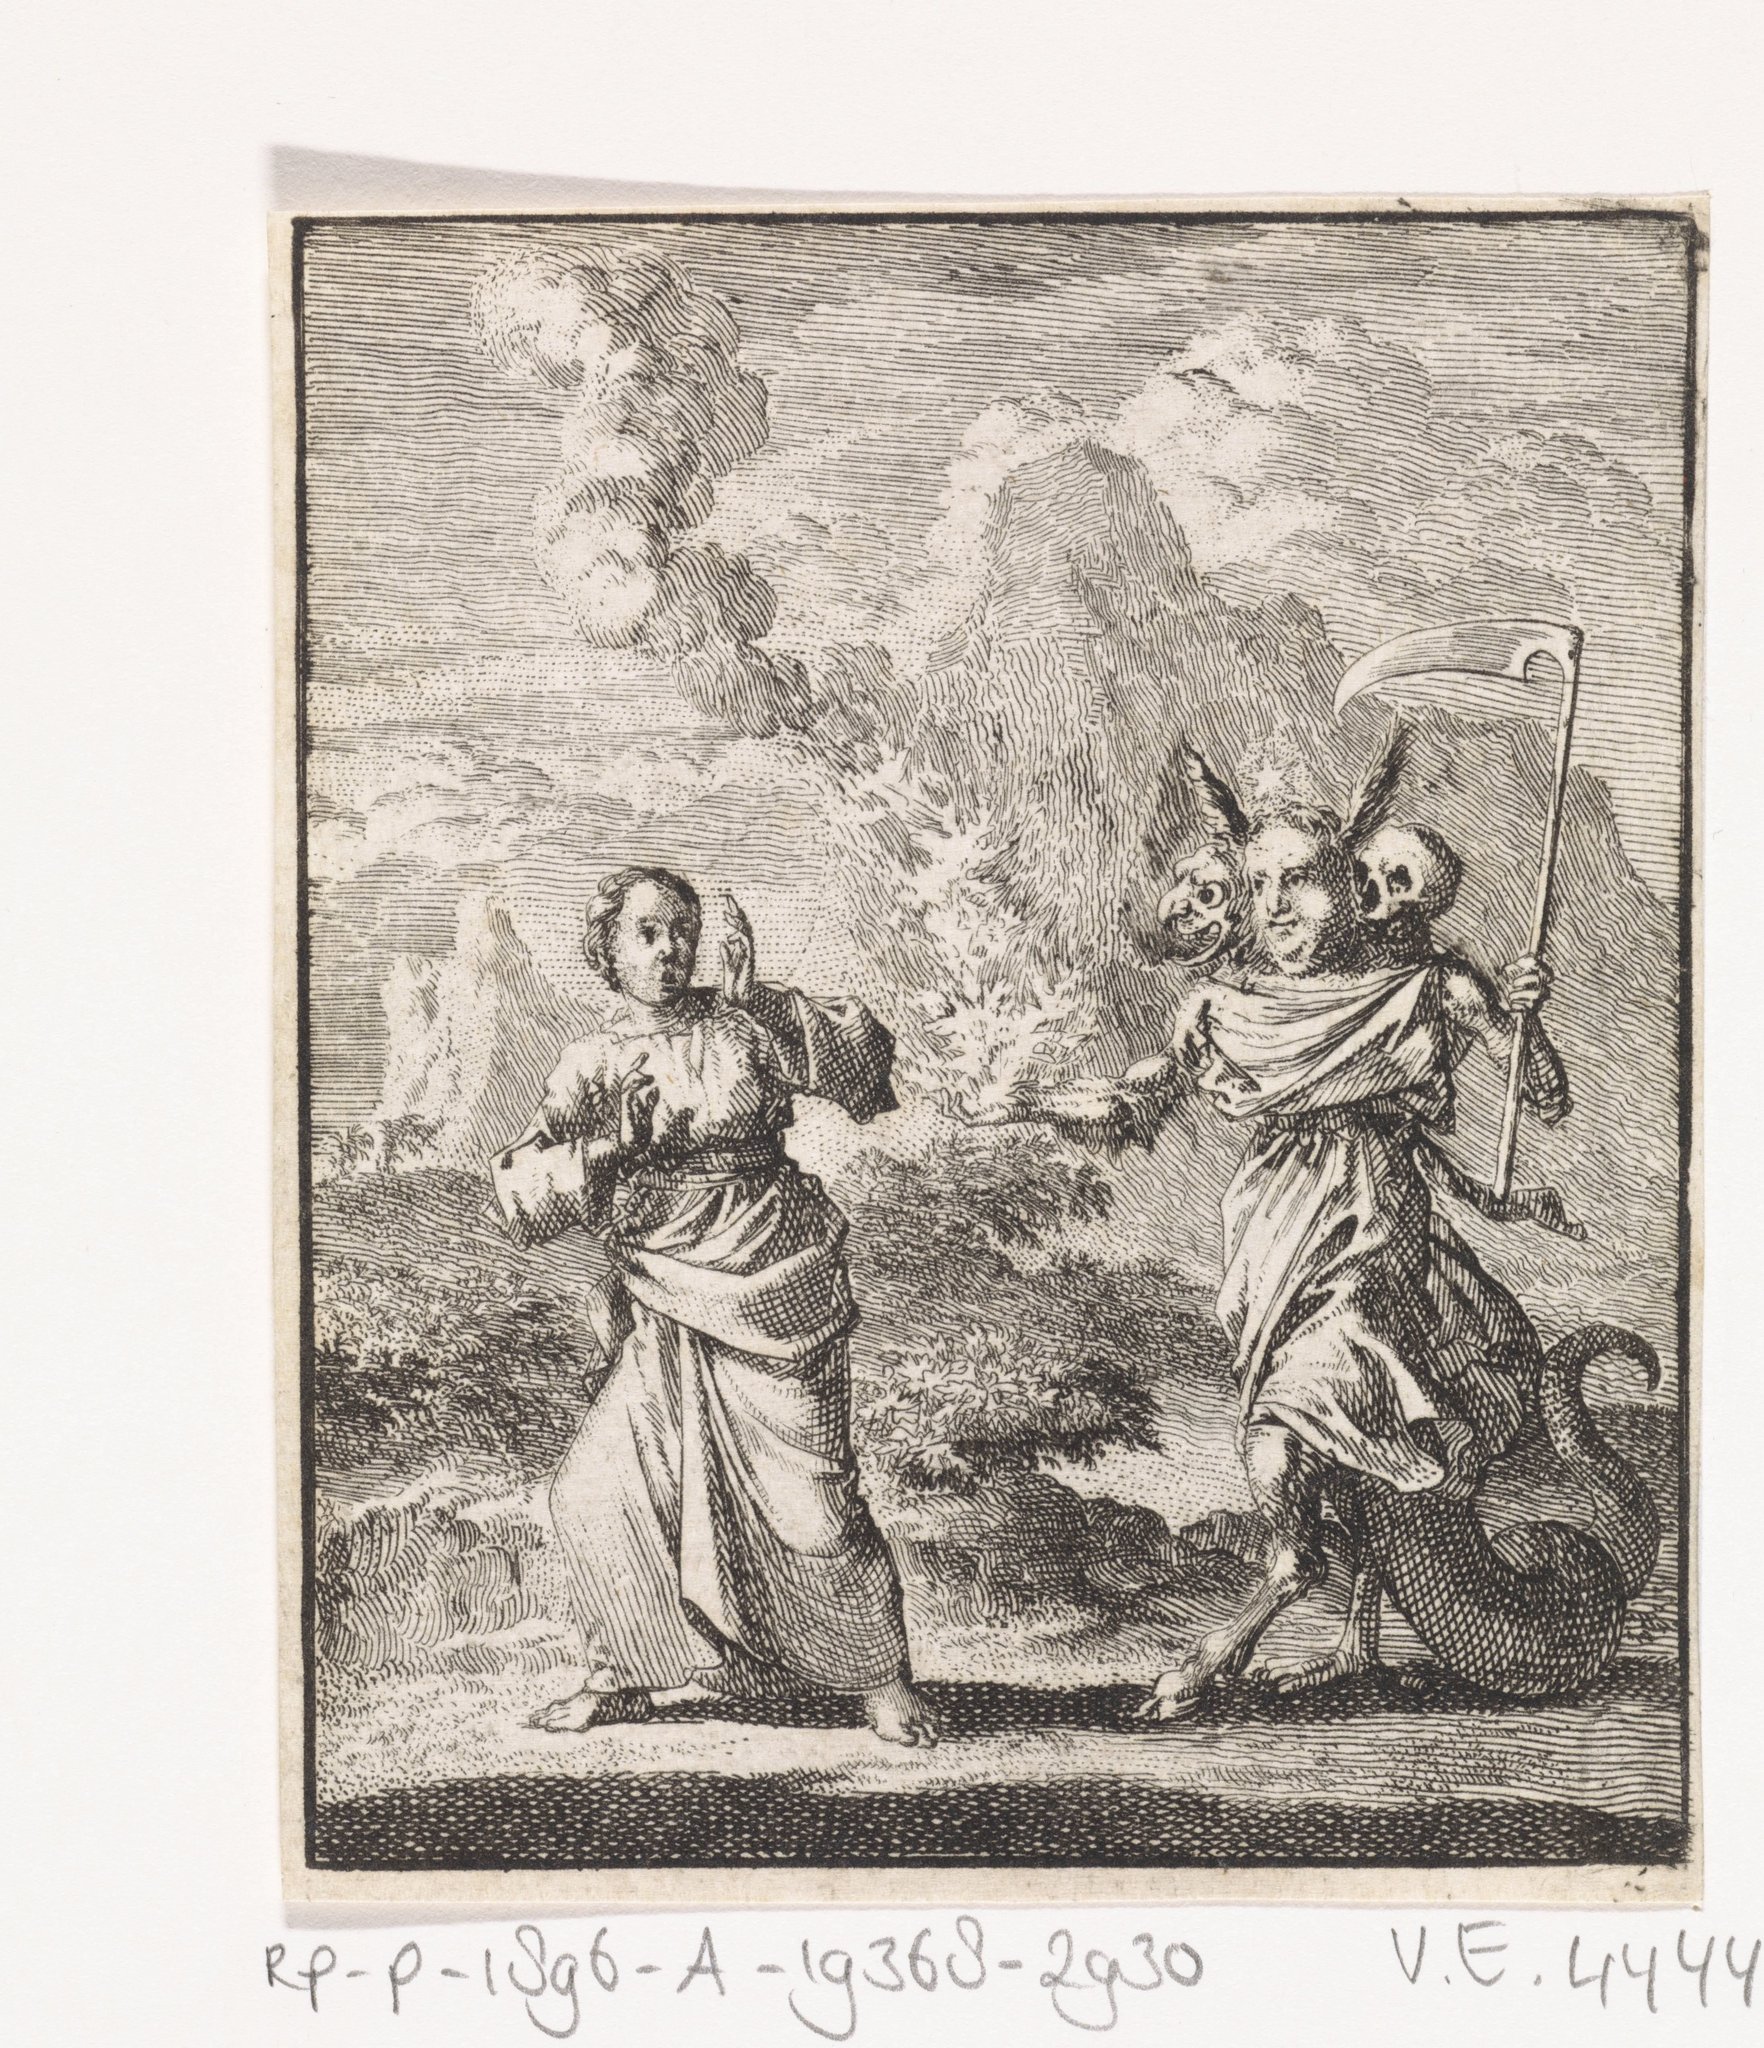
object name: print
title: De Ziel ontmoet de Zonde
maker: jan luyken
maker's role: draughtsman, print maker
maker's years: 1649-1712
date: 1714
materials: paper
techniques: etching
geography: amsterdam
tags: vice, evil, sin; 'peccato' (ripa), the soul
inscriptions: collector's mark: Lugt 2228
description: Proefdruk van illustratie uit: Luyken, Jan. Jezus en de Ziel, 3 delen. Amsterdam: Wed. Pieter Arentsz II en Cornelis van der Sys, 1714, dl. I, p. 23.